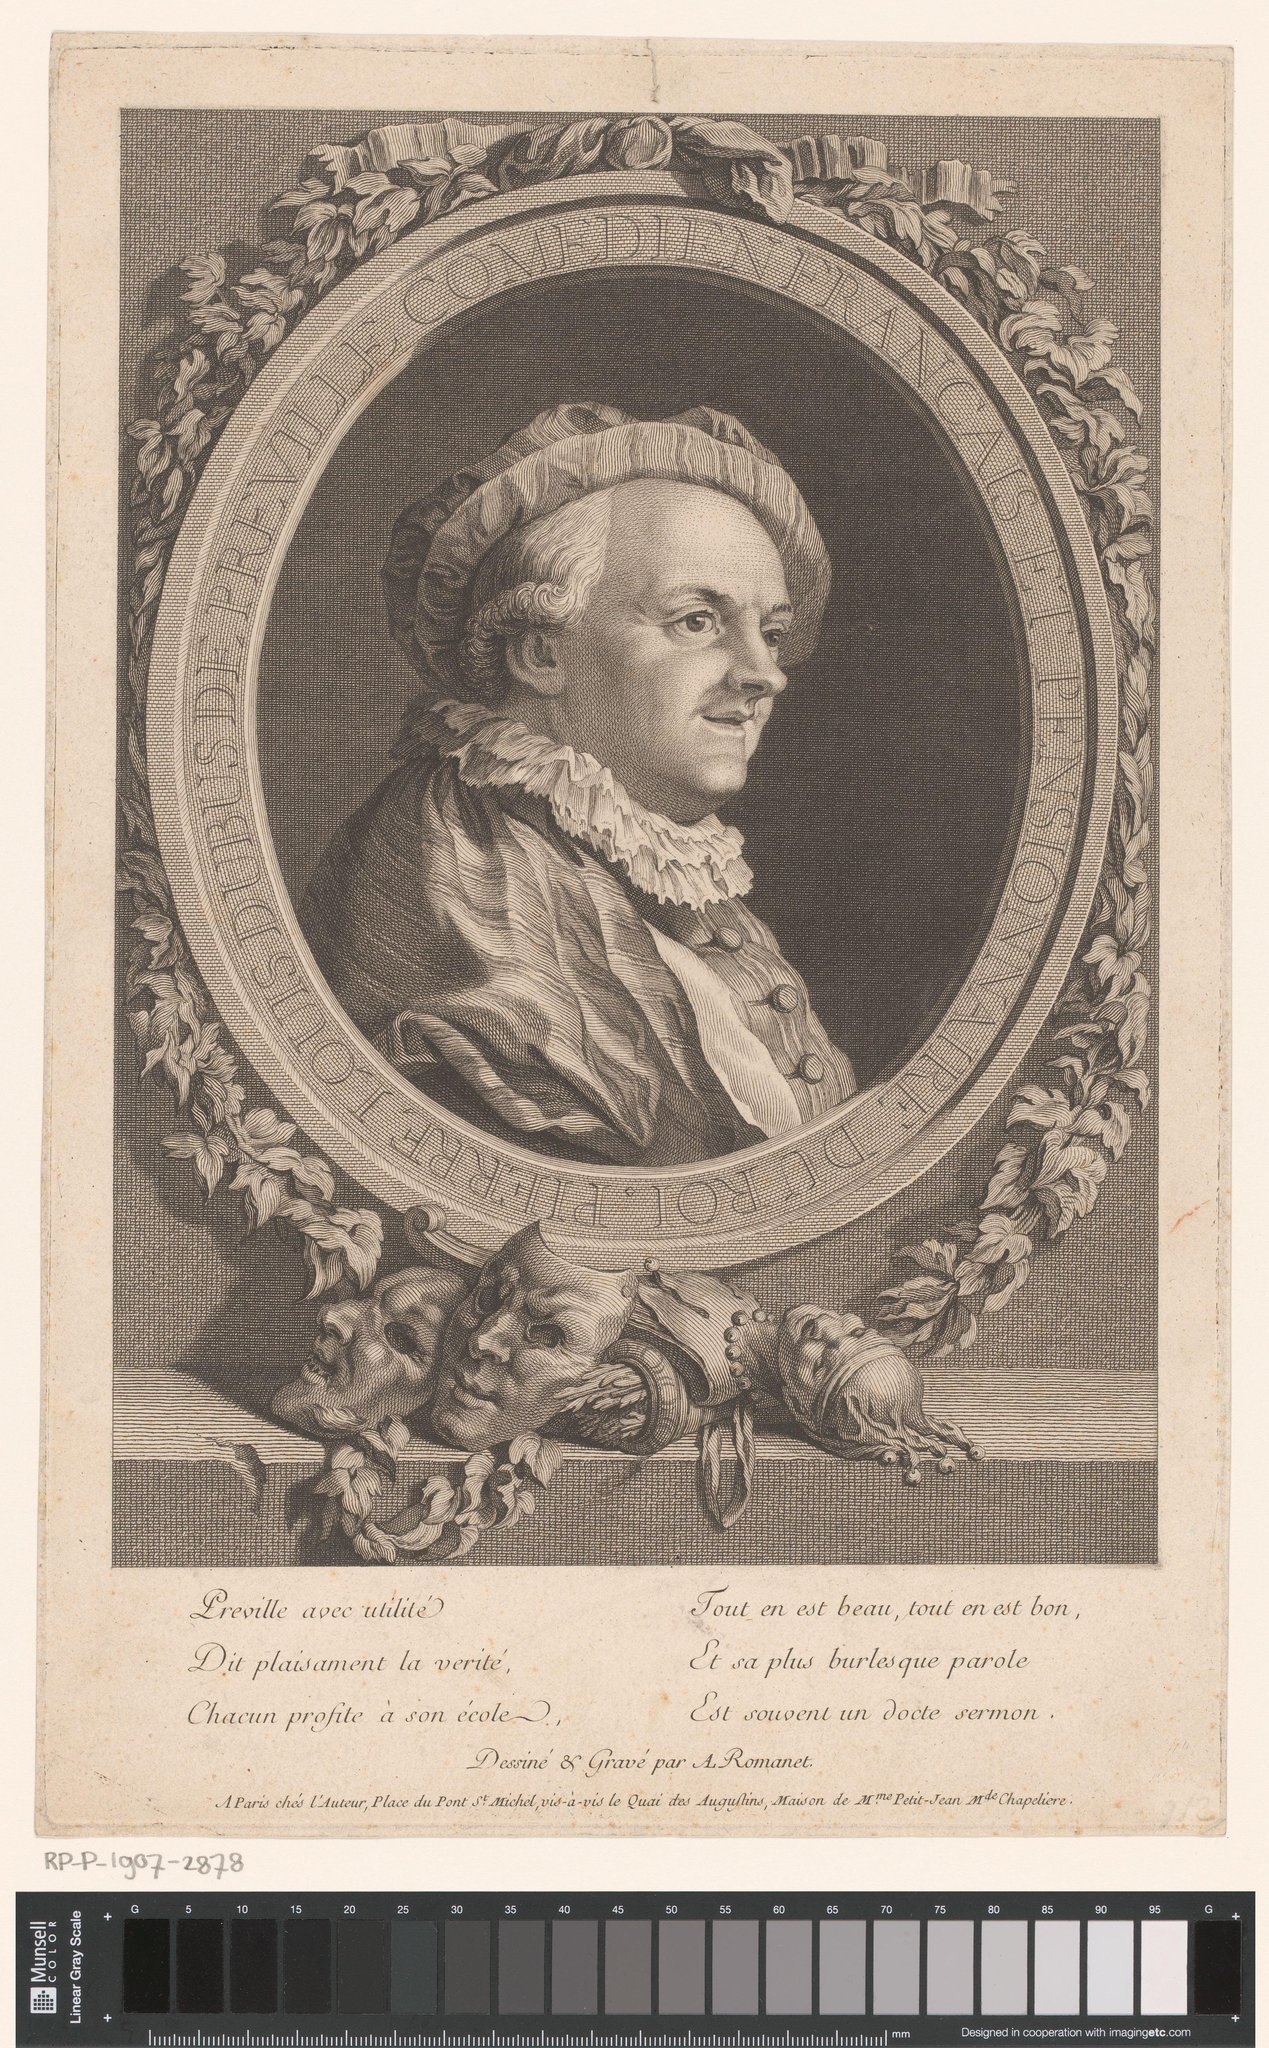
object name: print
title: Portret van Pierre Louis-Dubus de Preville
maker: antoine louis romanet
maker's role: print maker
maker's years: 1742-1810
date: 1752-1810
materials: paper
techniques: engraving, etching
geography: paris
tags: historical persons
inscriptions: collector's mark: Lugt 2228